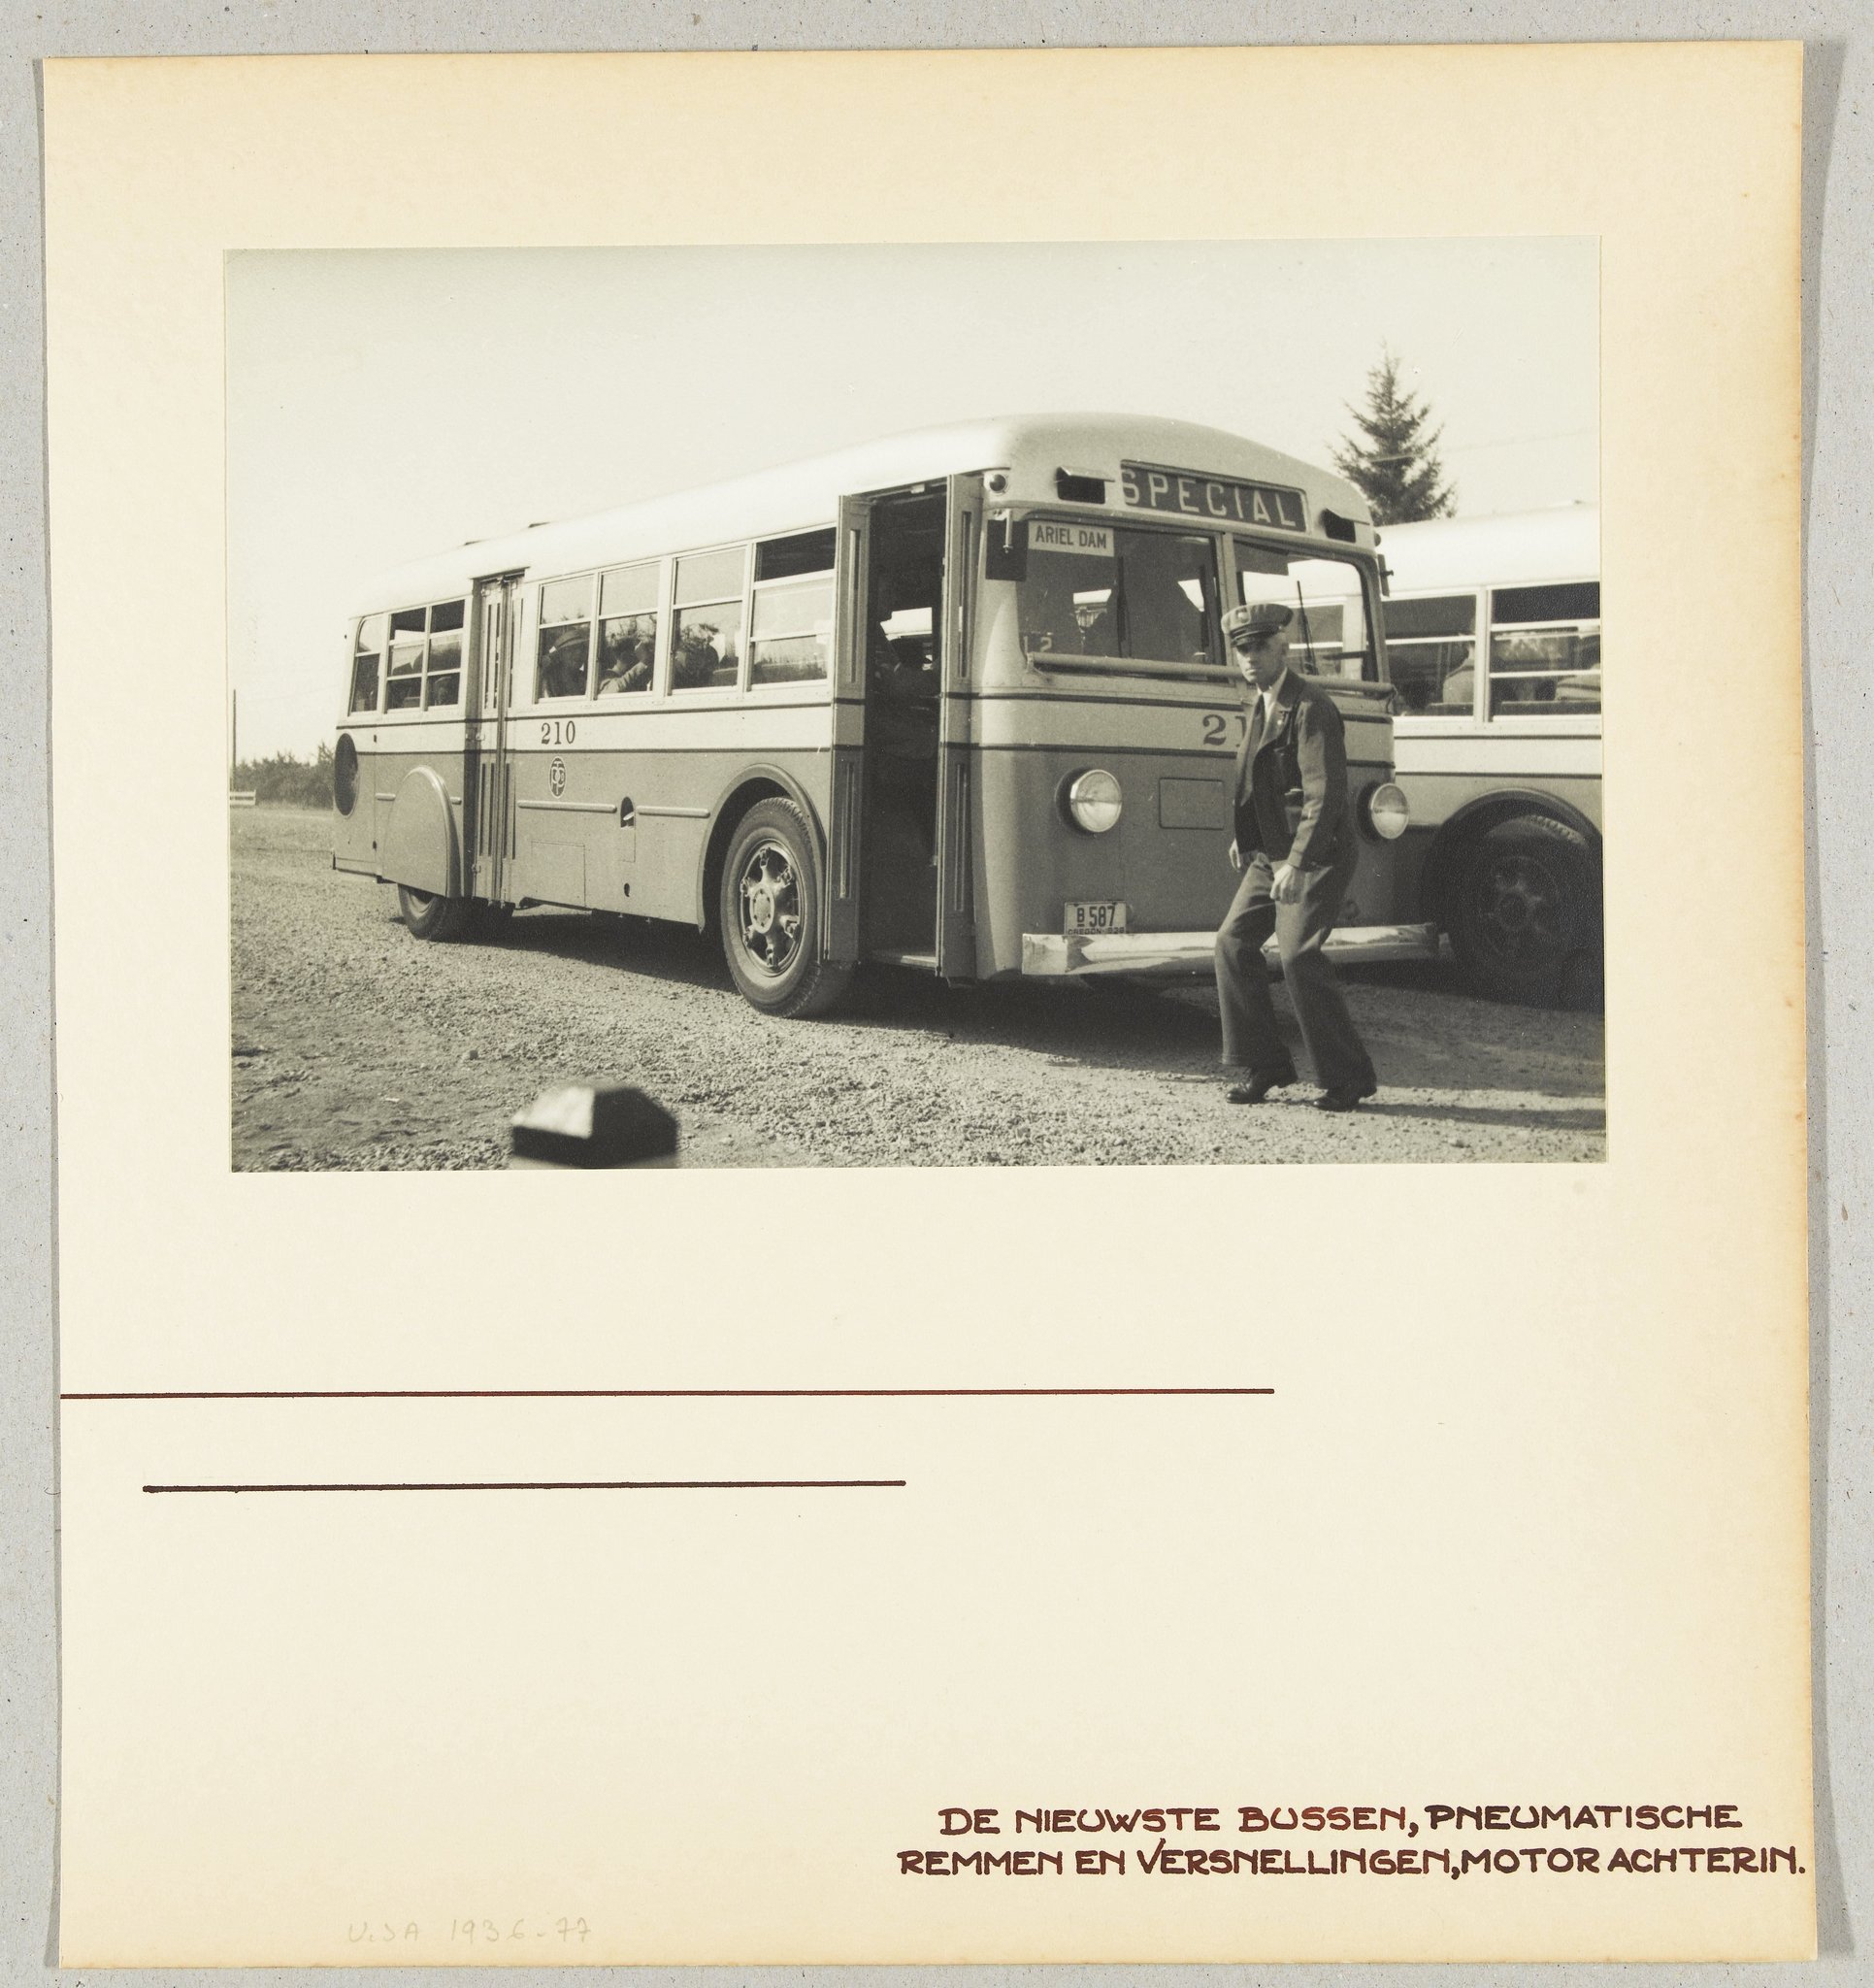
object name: photograph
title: Ariel Dam, Washington [staat], Verenigde Staten: autobus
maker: wouter cool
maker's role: engineer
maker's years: 1877-1947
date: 1936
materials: cardboard, paper, photographic support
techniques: gelatin silver print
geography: united states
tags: bus, coach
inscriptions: title: ‘DE NIEUWSTE BUSSEN, PNEUMATISCHE / REMMEN EN VERSNELLINGEN, MOTOR ACHTERIN.’